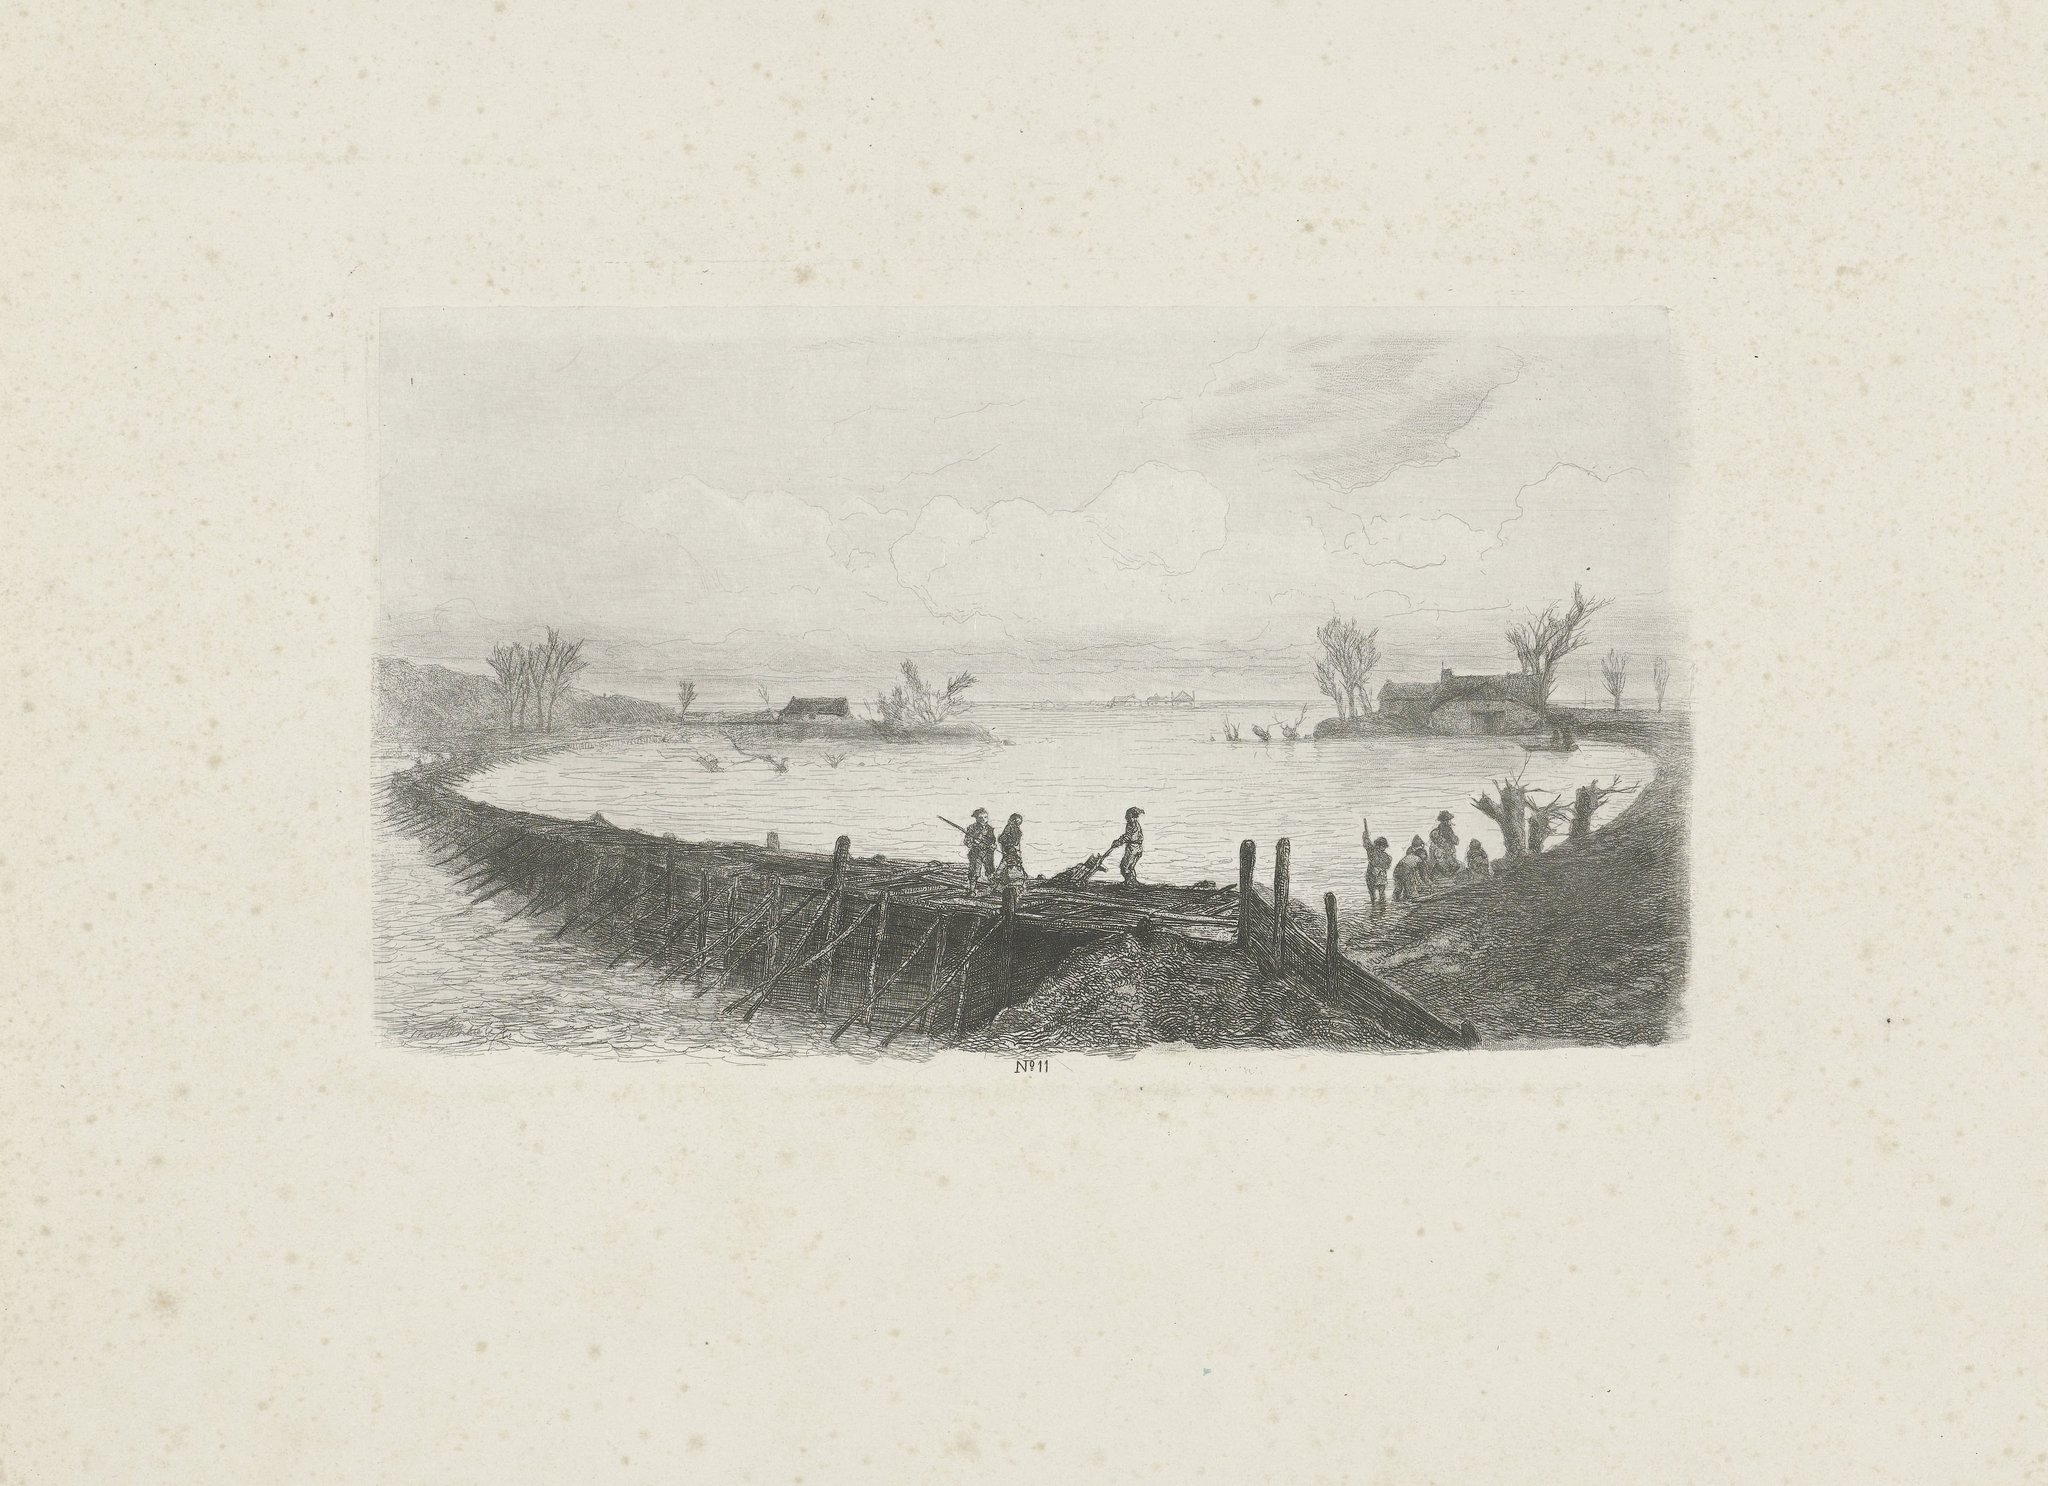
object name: print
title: Beringing van de doorbraak te Speet, 1855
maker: mari ten kate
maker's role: draughtsman, painter, print maker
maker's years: 1831-1910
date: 1855-1860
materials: paper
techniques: etching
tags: flood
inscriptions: collector's mark: Lugt 2228, collector's mark: Lugt 2760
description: Beringing van de doorbraak te Speet, 9 maart 1855. Op de voorgrond zijn enkele figuren bezig om een nooddijk aan te leggen om het water te weren. Op de achtergrond zijn een aantal onder water gelopen bomen en huizen te zien. Deze prent maakt deel uit van een serie bestaande uit 24 prenten over de watersnoodramp van 1855.